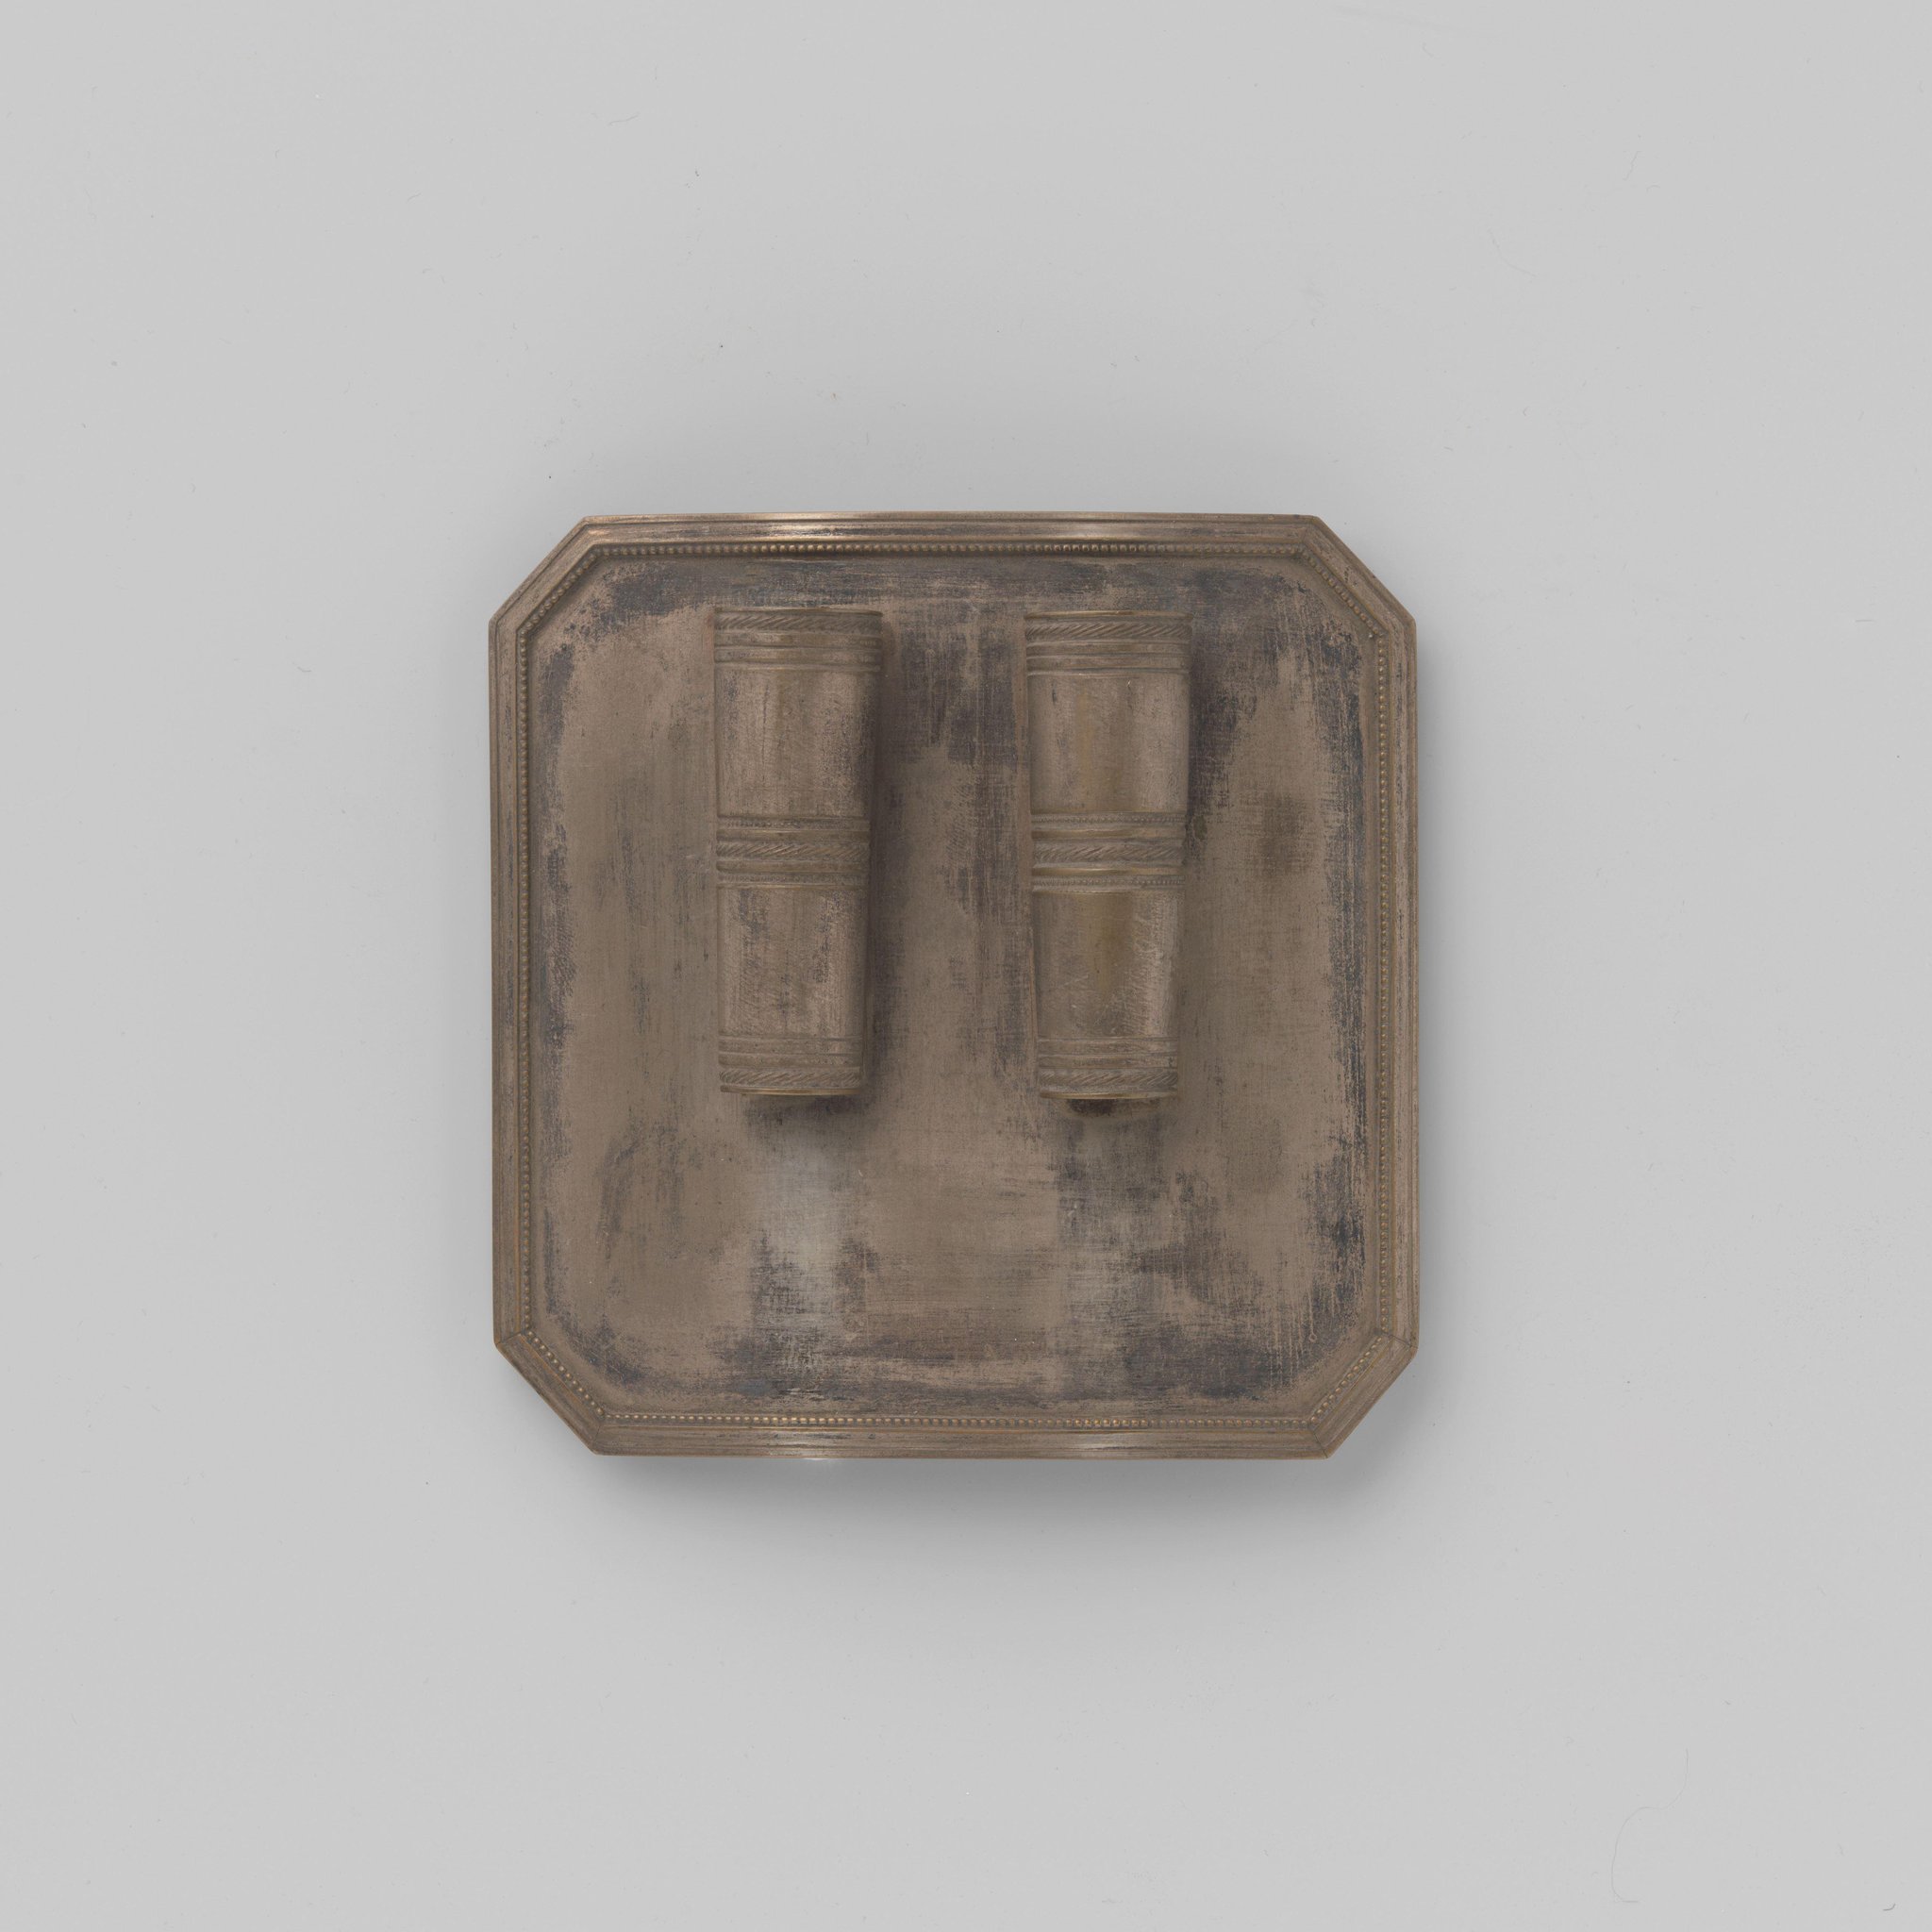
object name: stick plate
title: Drumstick holder from a drummers belt plate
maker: Anonymous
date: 1823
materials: copper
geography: netherlands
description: Stokplaat van messing voor tamboer-majoor